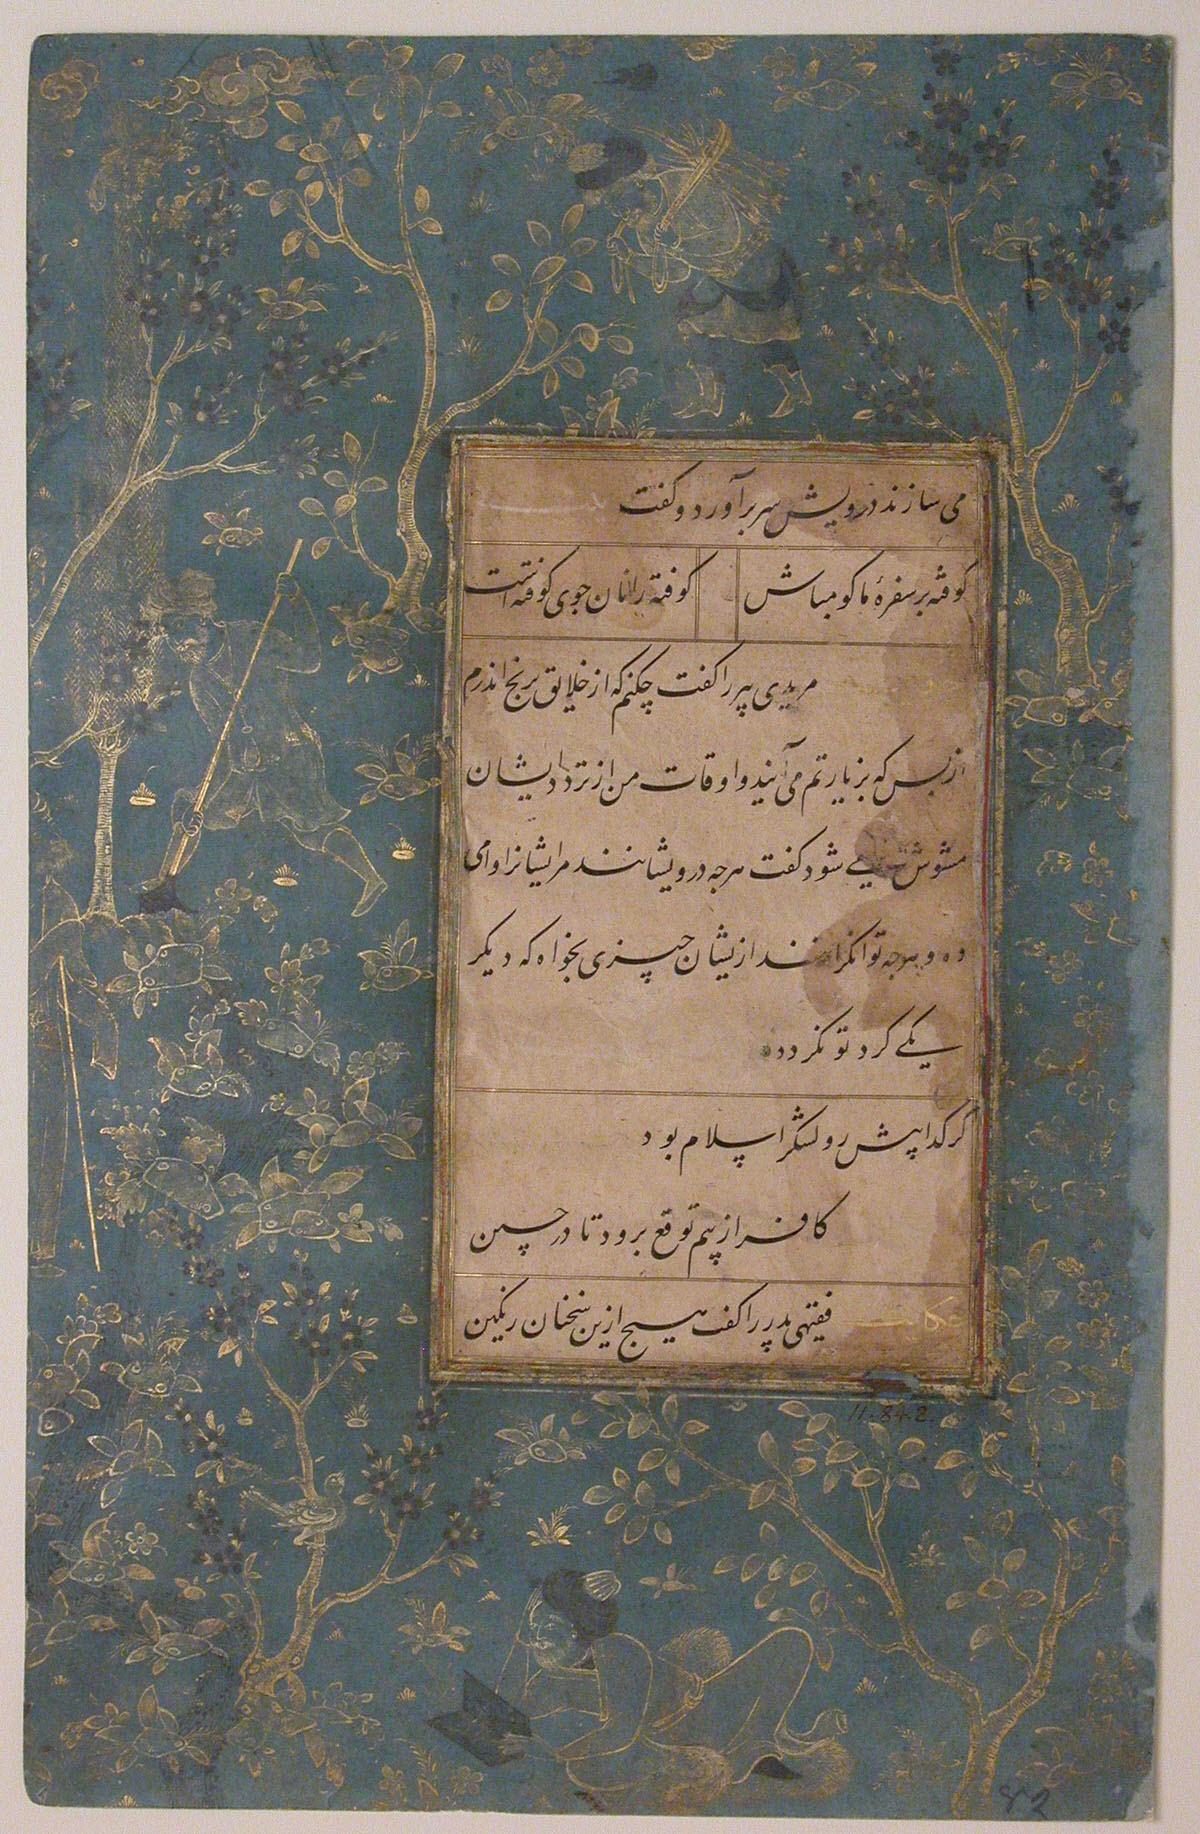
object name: folio from a non illustrated manuscript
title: Page of Calligraphy from an Anthology of Poetry by Sa`di and Hafiz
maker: sa'di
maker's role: author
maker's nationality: iranian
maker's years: 1213-1291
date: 1467-1500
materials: gold, ink, paper, silver, watercolor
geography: afghanistan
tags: poetry,men,persian,flowers,calligraphy